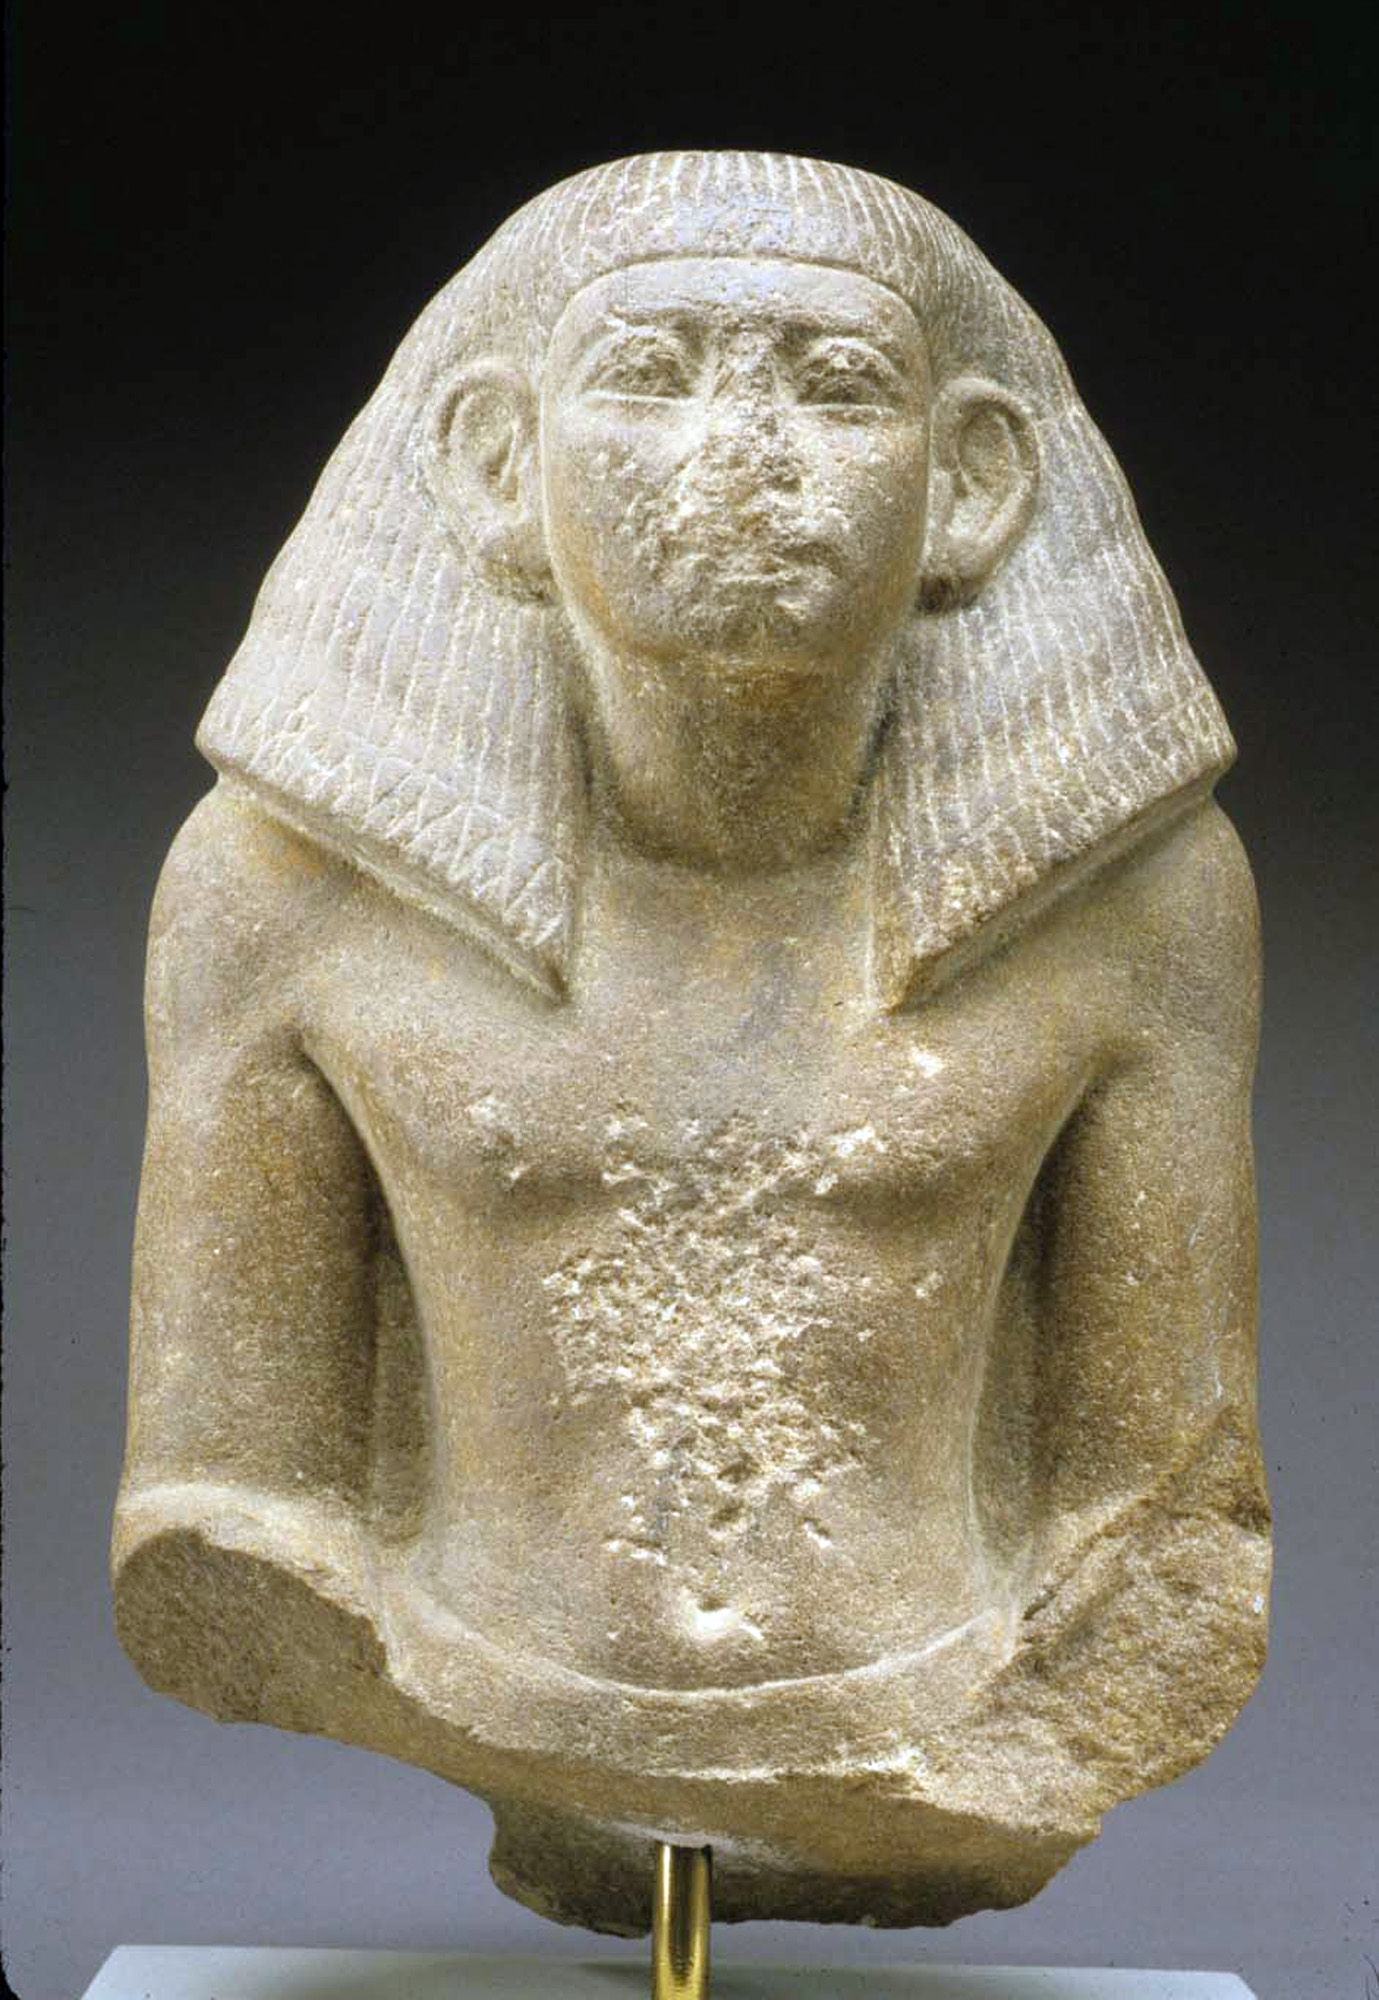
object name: statue, upper part, seated with pointed wig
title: Statuette of a man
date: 1850-1800 BCE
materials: quartzite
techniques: painting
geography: egypt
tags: men